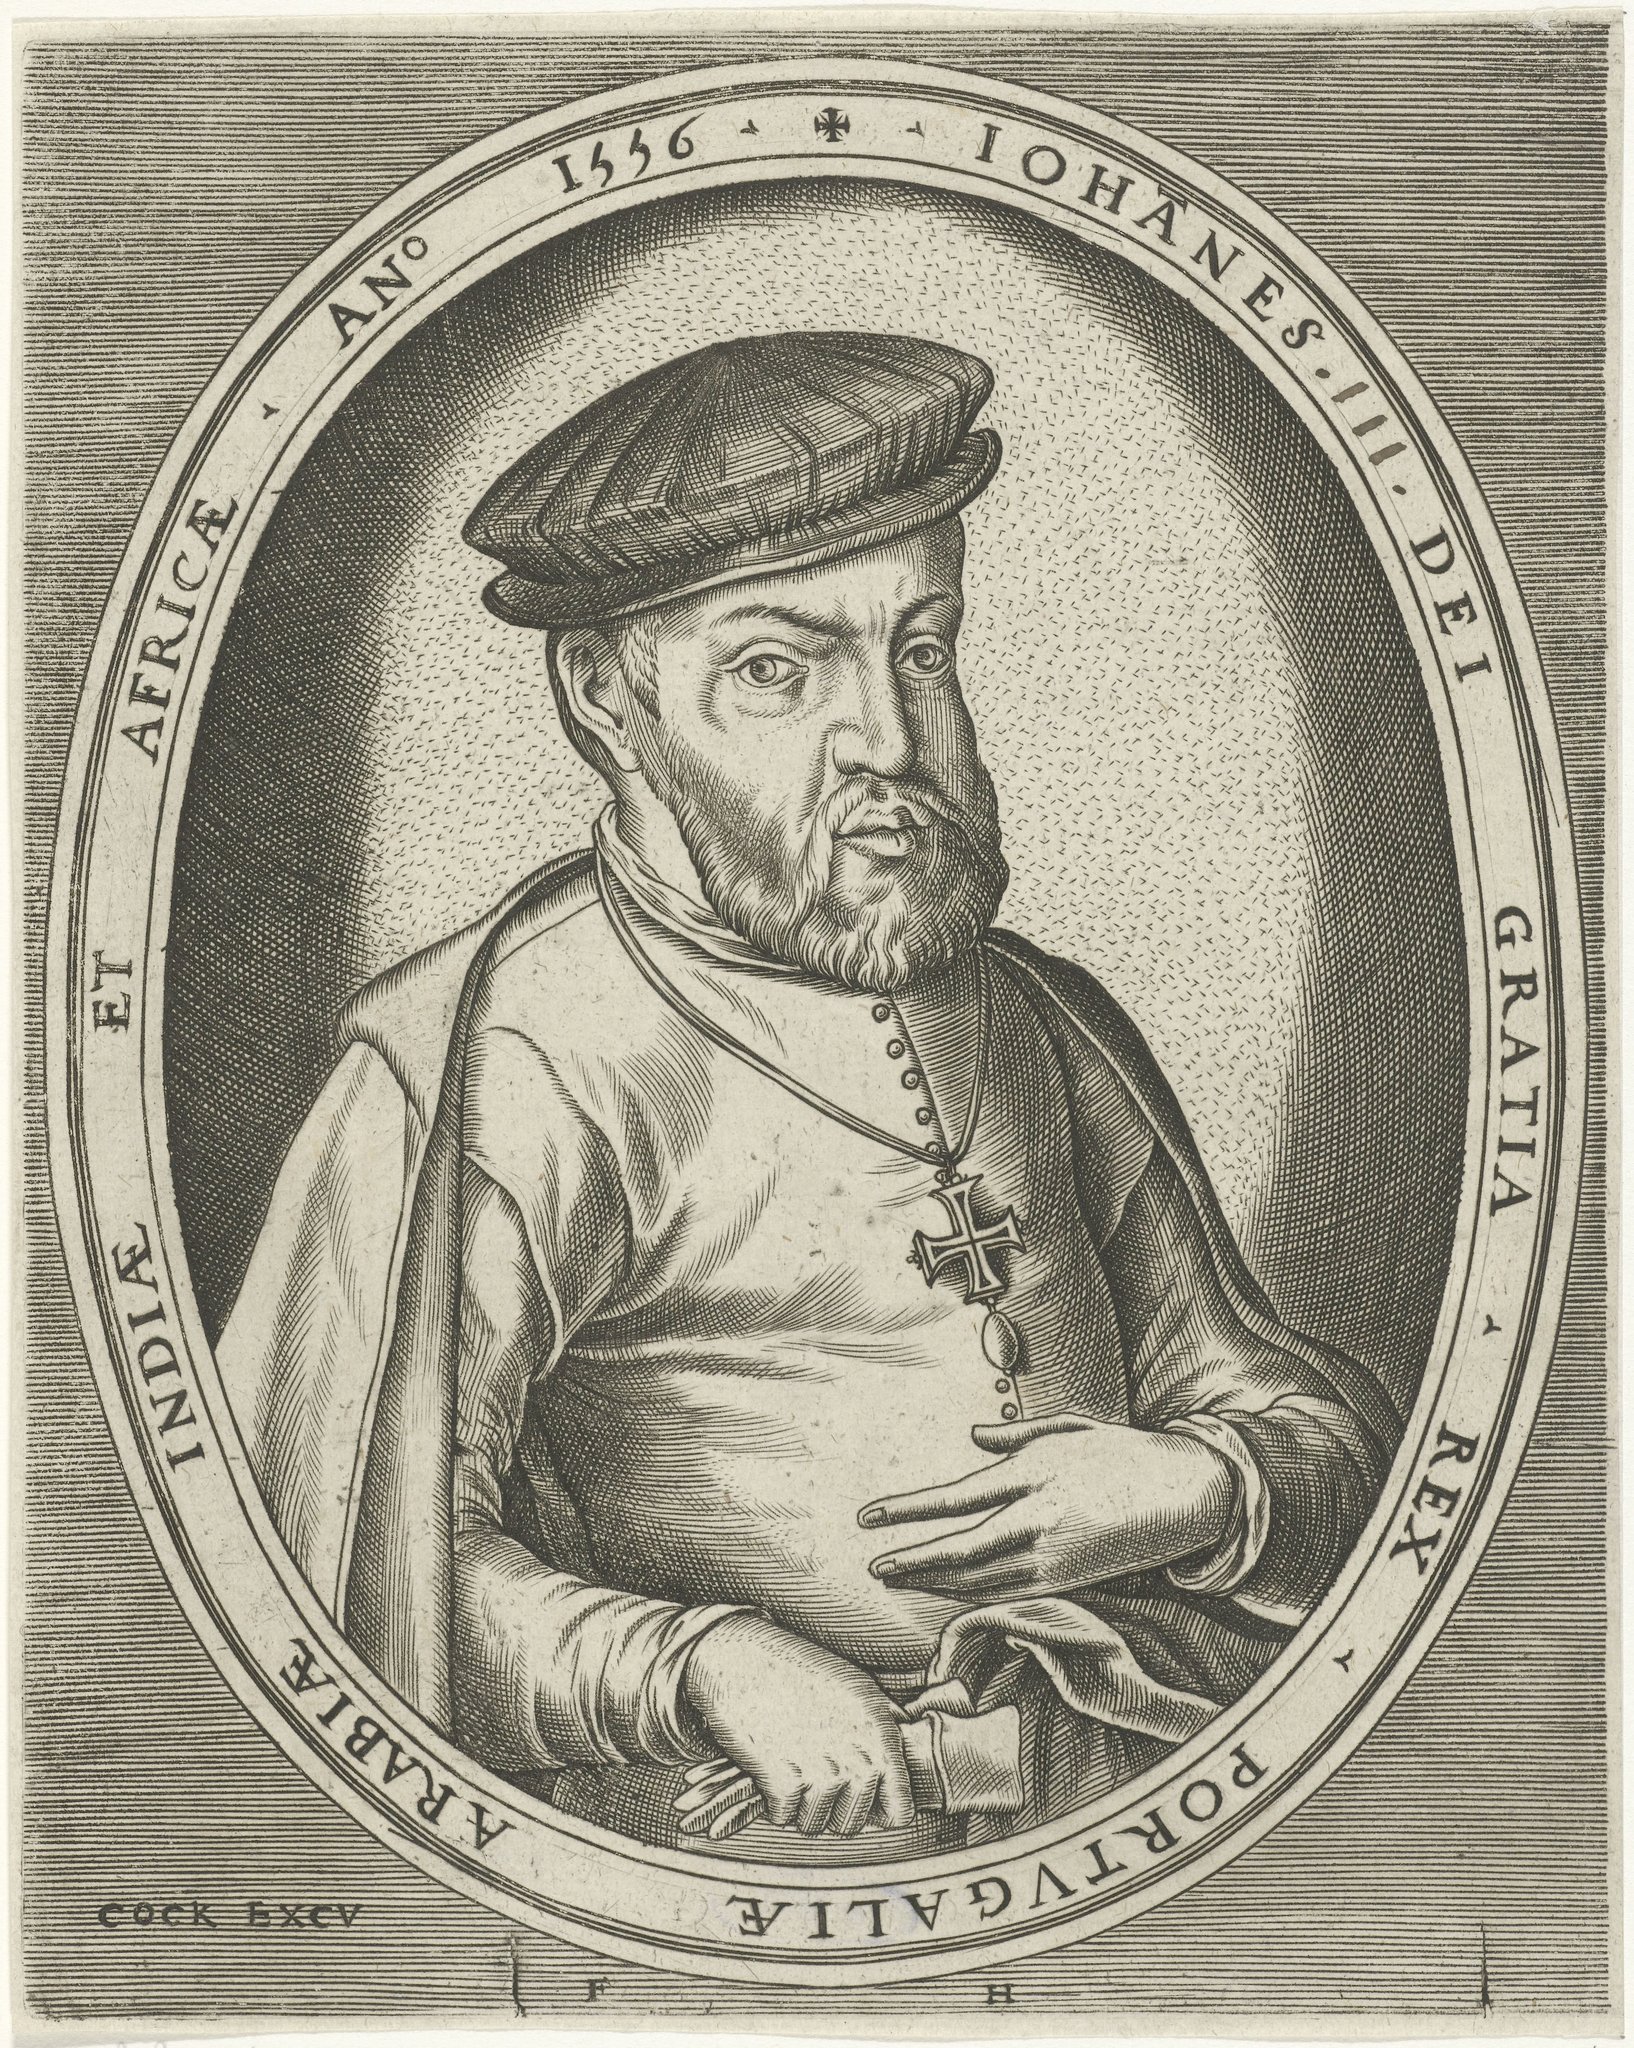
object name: print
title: Portretten van koningen, koninginnen, prinsen en prinsessen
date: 1556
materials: paper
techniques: engraving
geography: antwerp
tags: koning, johannes iii (koning van portugal)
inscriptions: collector's mark: Lugt 2228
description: Portret van Johannes III, koning van Portugal, ten halven lijve naar rechts met een paar handschoenen in zijn rechterhand in een ovale lijst met randschrift in het Latijn.